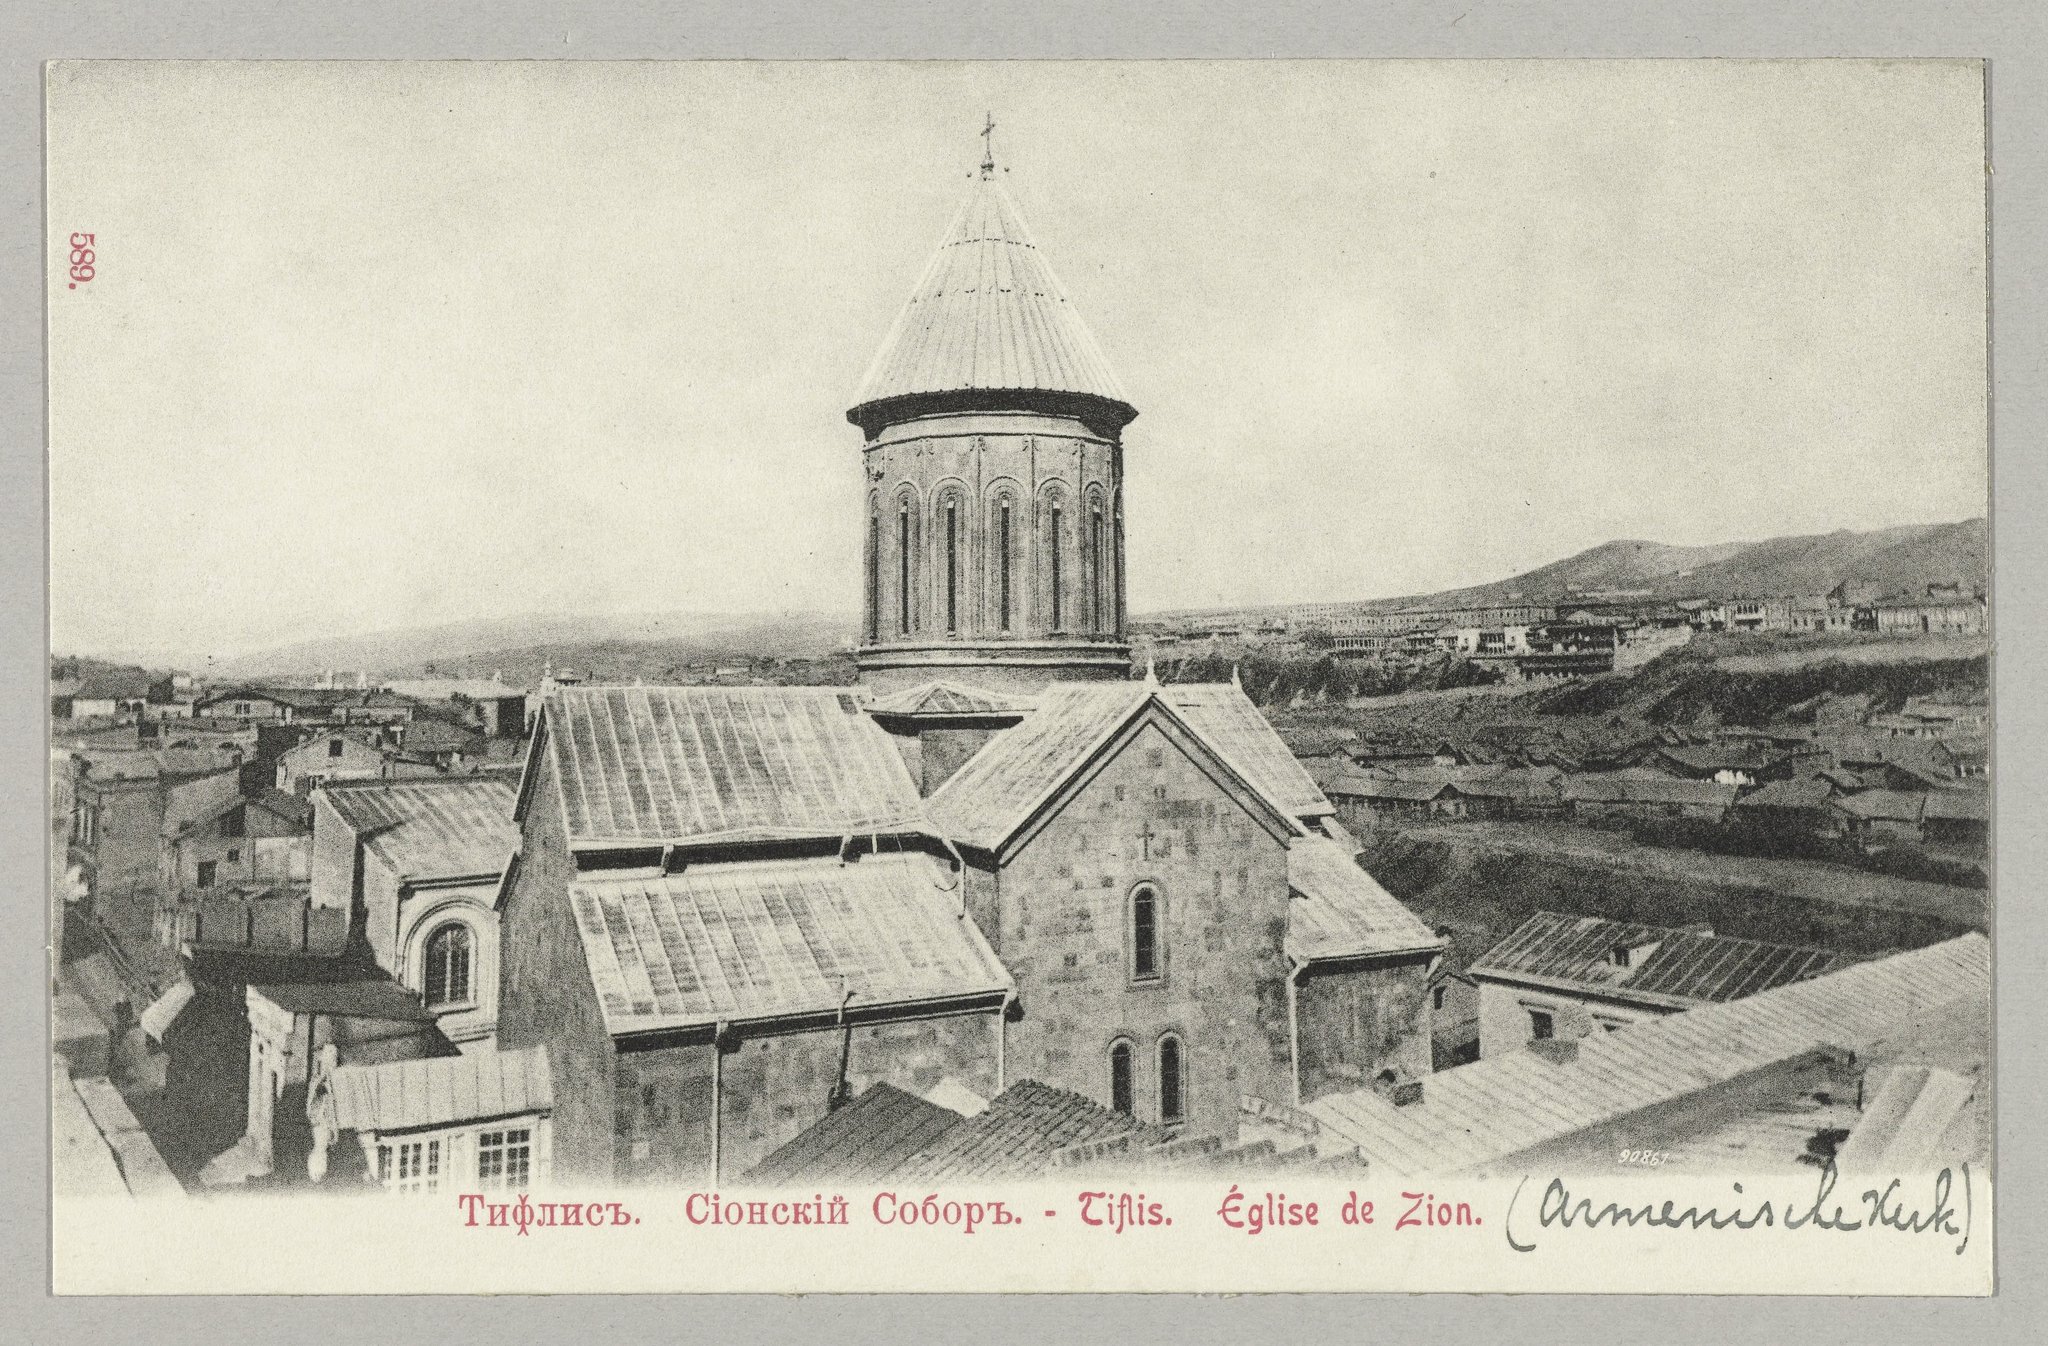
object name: photomechanical print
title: Tiflis. Eglise de Zion.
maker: Anonymous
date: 1895-1915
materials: cardboard, paper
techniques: photograph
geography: tbilisi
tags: tbilisi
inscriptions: number: ‘31.’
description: Bovenaan staat de titel in het Russisch en Frans weergegeven. Achter de Franse titel is geschreven: (armenische kerk). Linksboven staat verticaal het nummer 589.